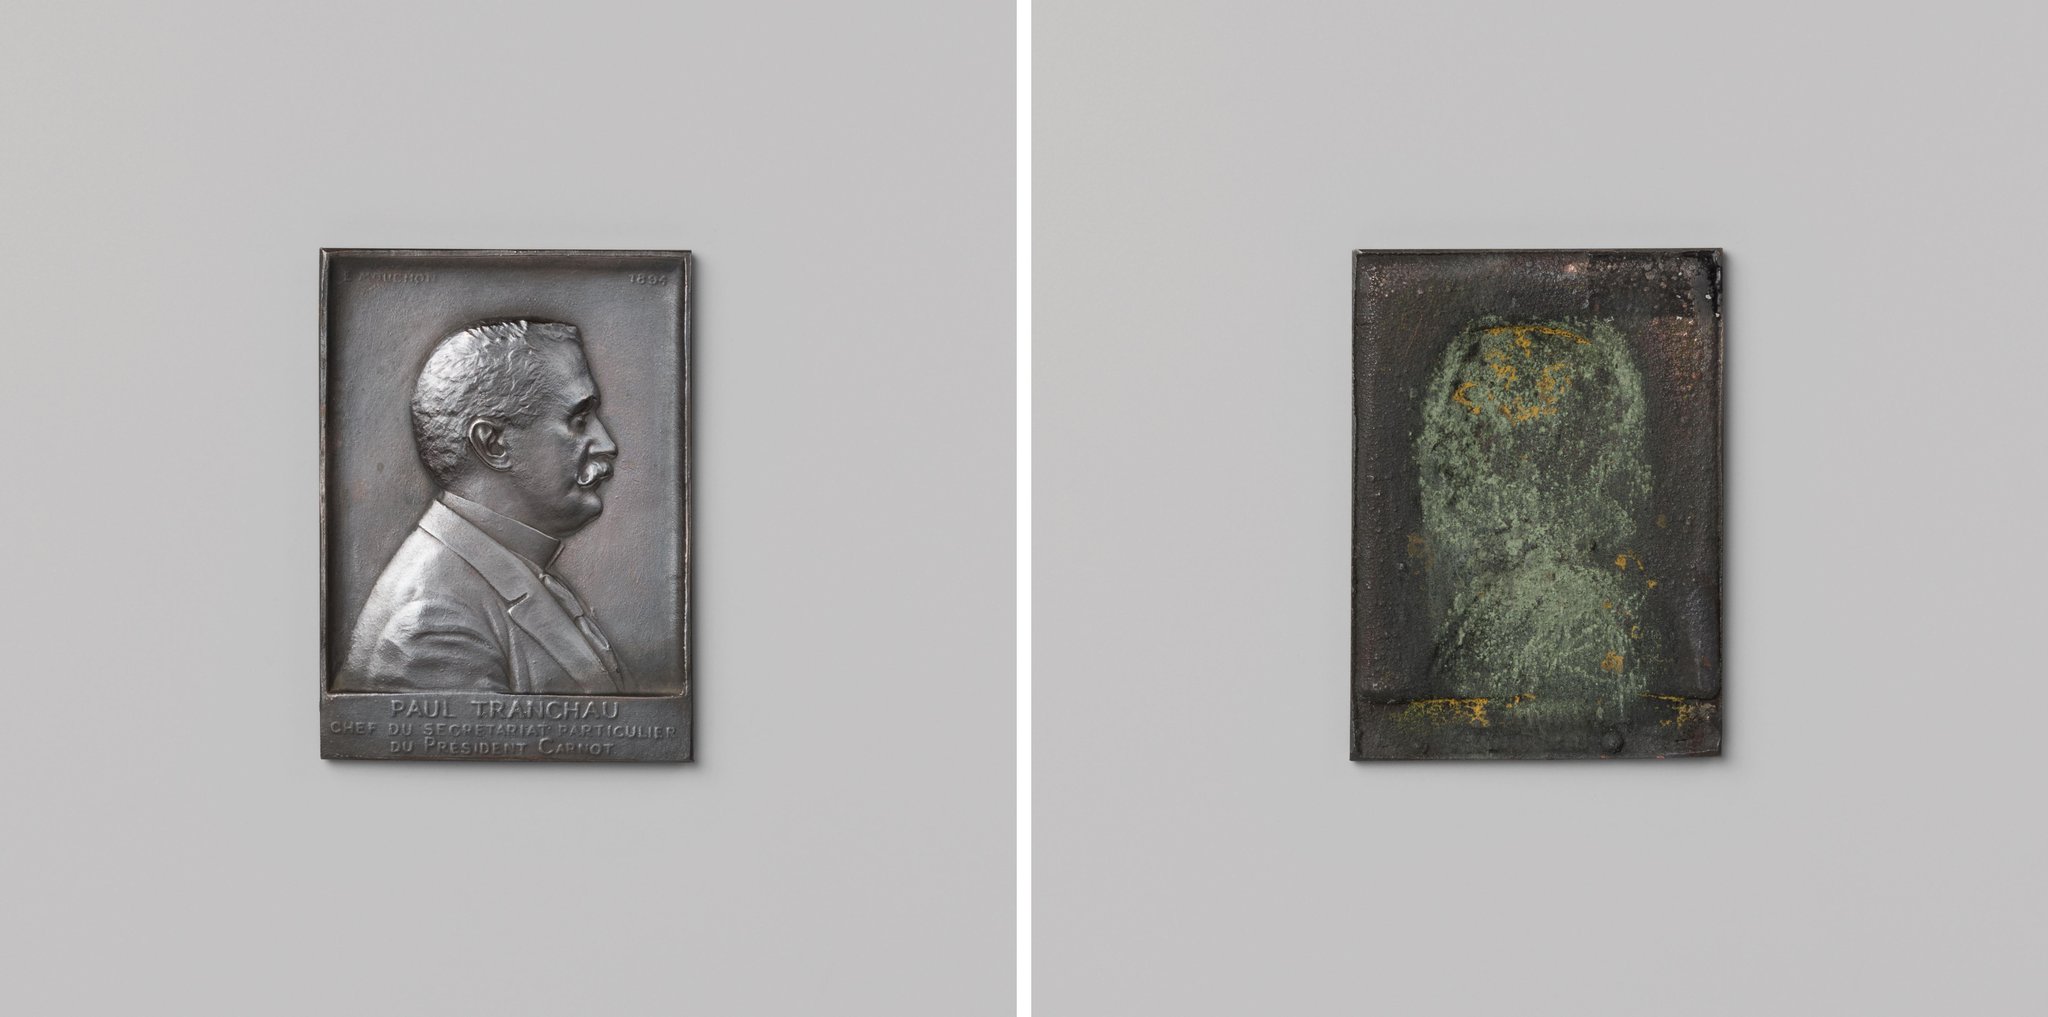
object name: honorary medal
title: Paul Tranchau, hoofd van het particulier secretariaat van president Carnot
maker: louis eugène mouchon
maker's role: medailleur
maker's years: 1843-1914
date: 1894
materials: silver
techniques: casting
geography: paris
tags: paris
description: Eenzijdige zilveren rechthoekige penning. Voorzijde: borststuk man; afsnede: opschrift. Keerzijde: blanco